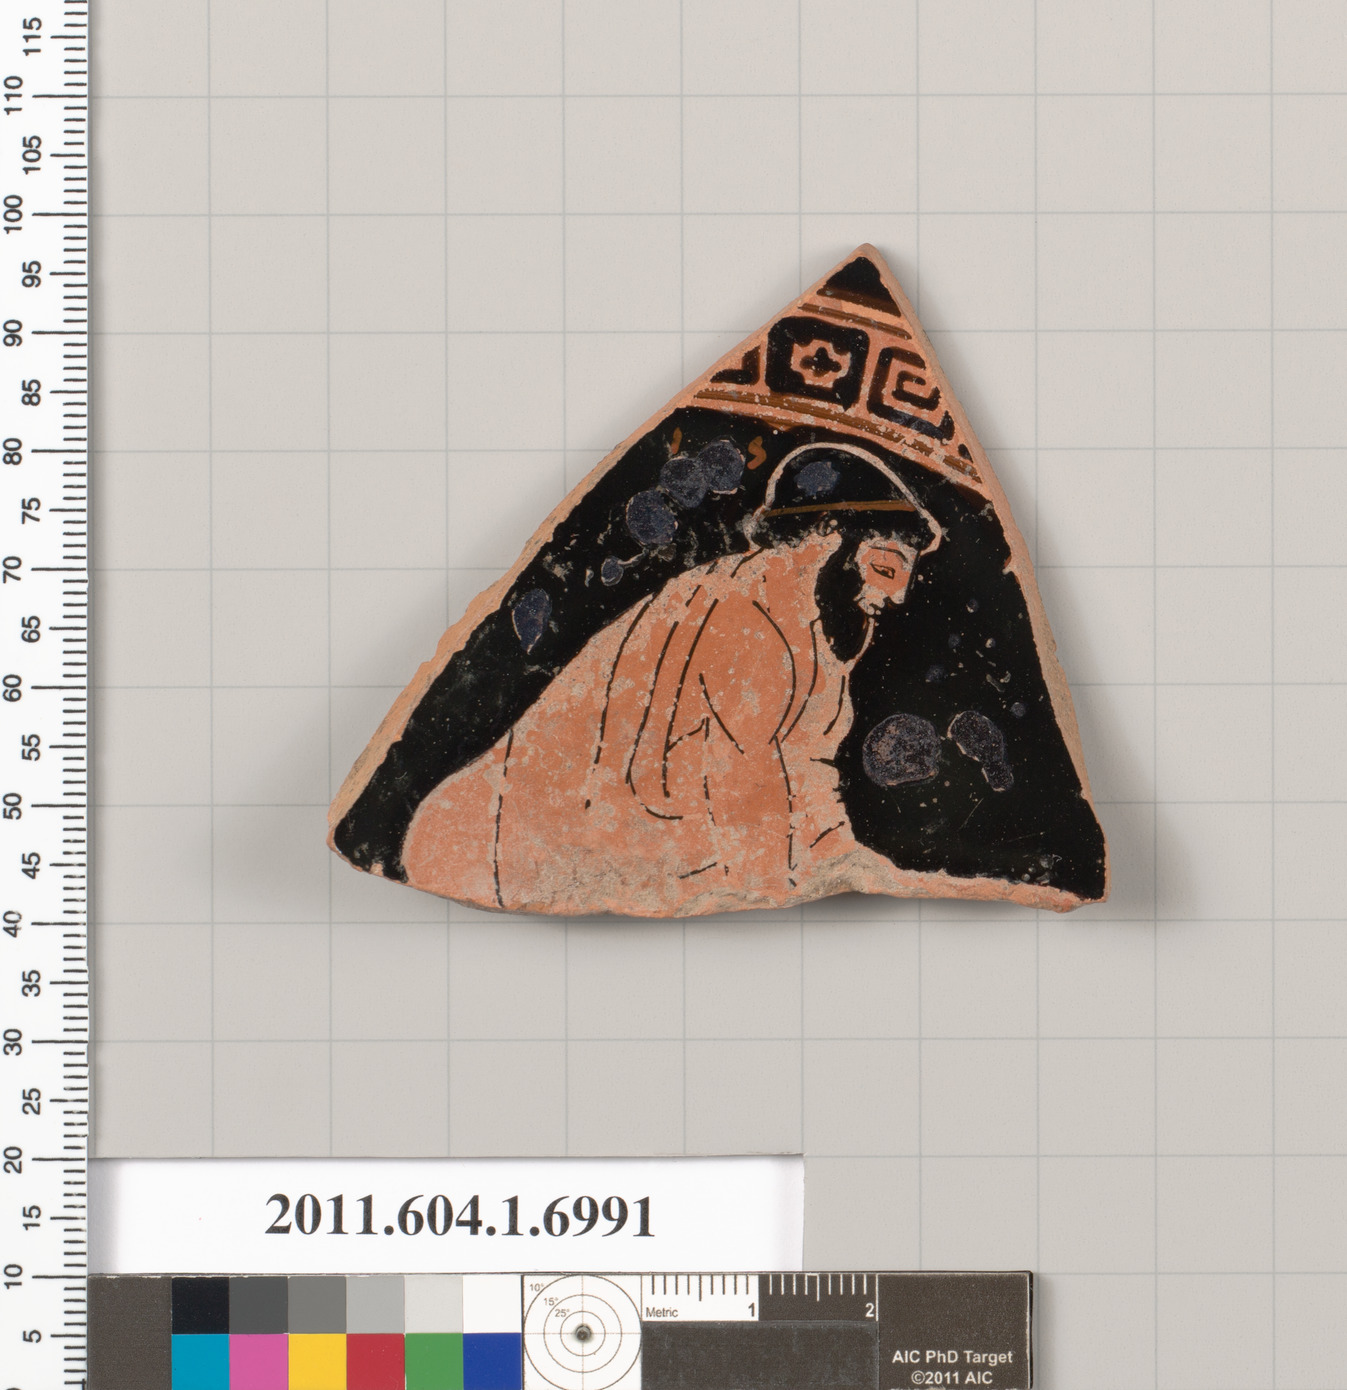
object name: kylix fragment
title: Terracotta fragment of a kylix (drinking cup)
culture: greek, attic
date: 500-480 BCE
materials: terracotta